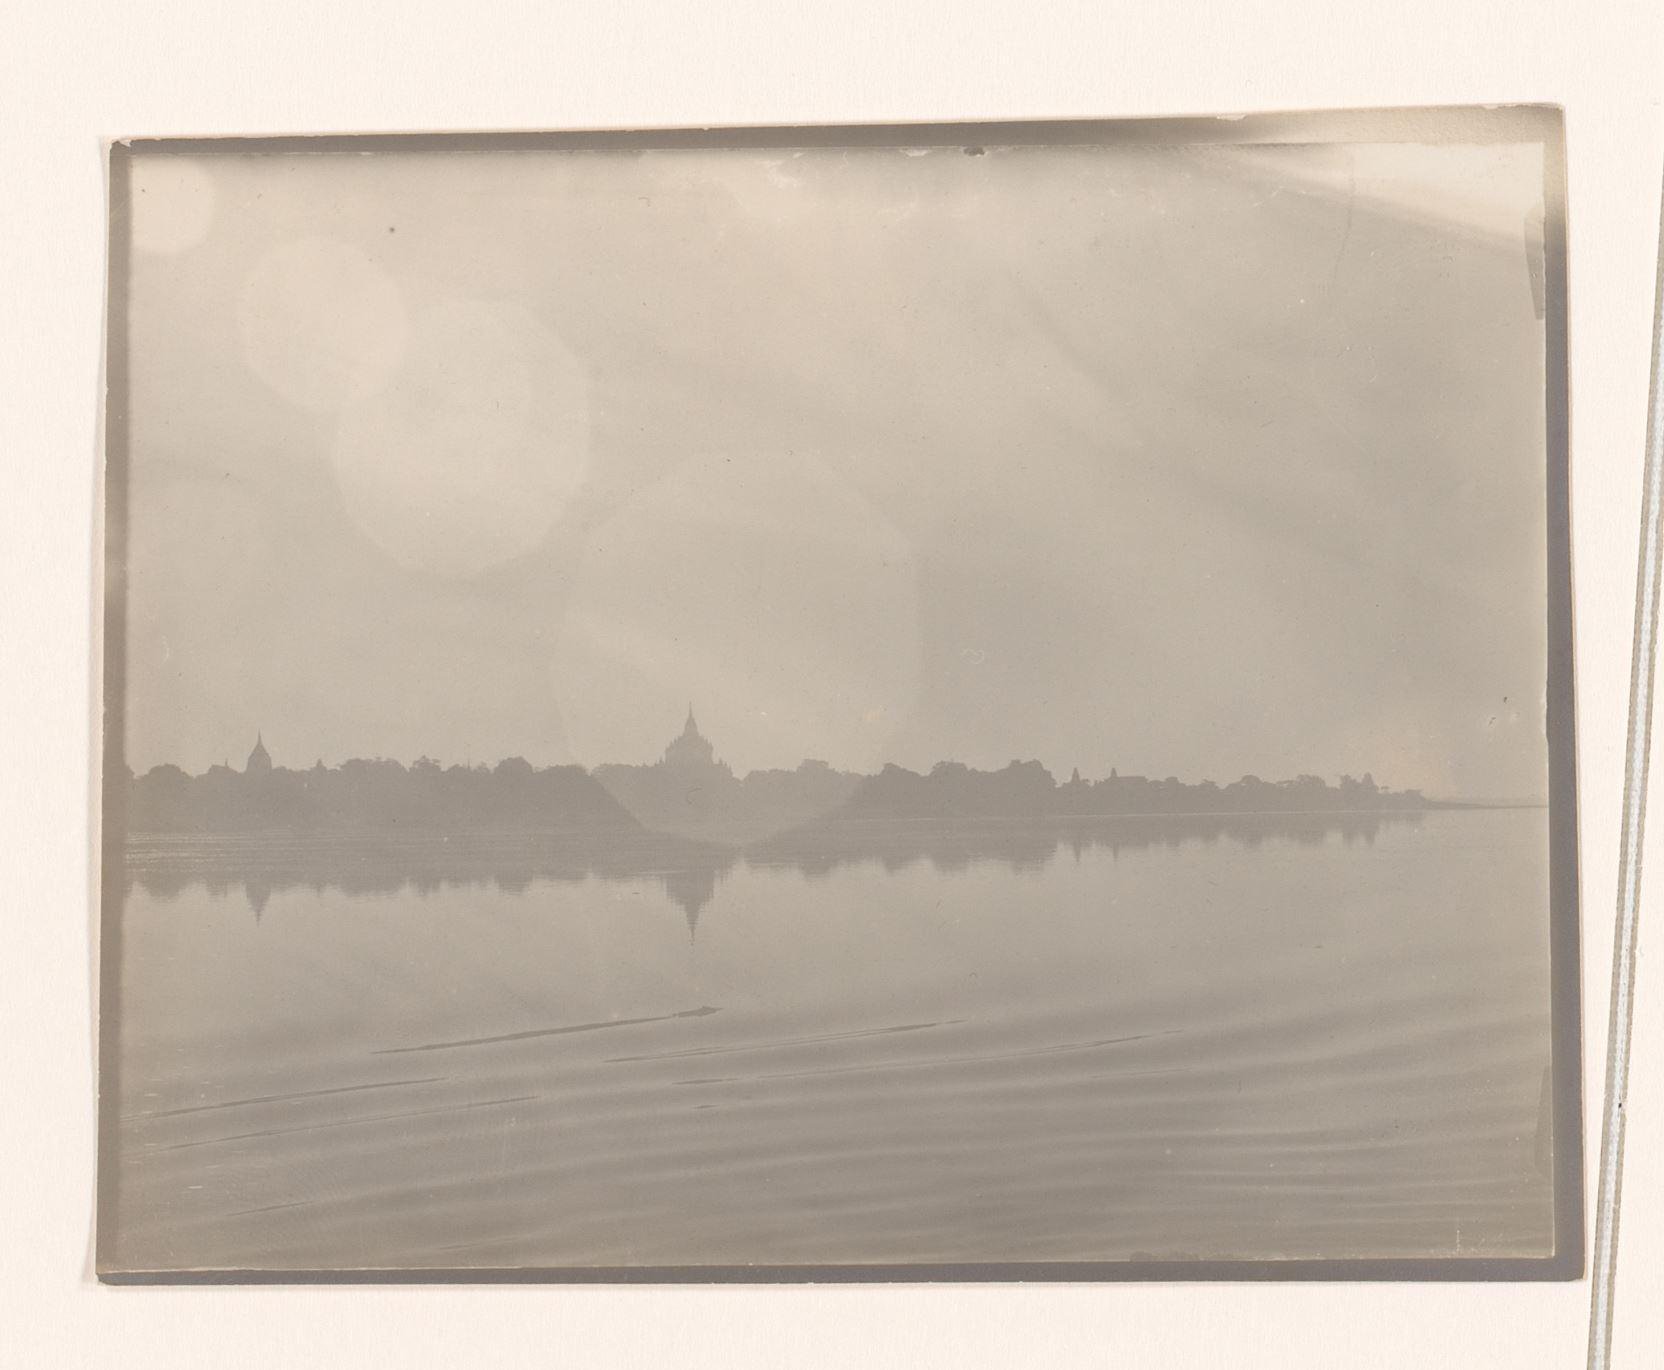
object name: photograph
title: Gezicht op enkele tempels op de begroeide oever van een rivier, Zuid-Oost Azië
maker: jan adriani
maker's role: fotograaf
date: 1907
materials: photographic support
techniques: gelatin silver print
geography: southeast asia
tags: river